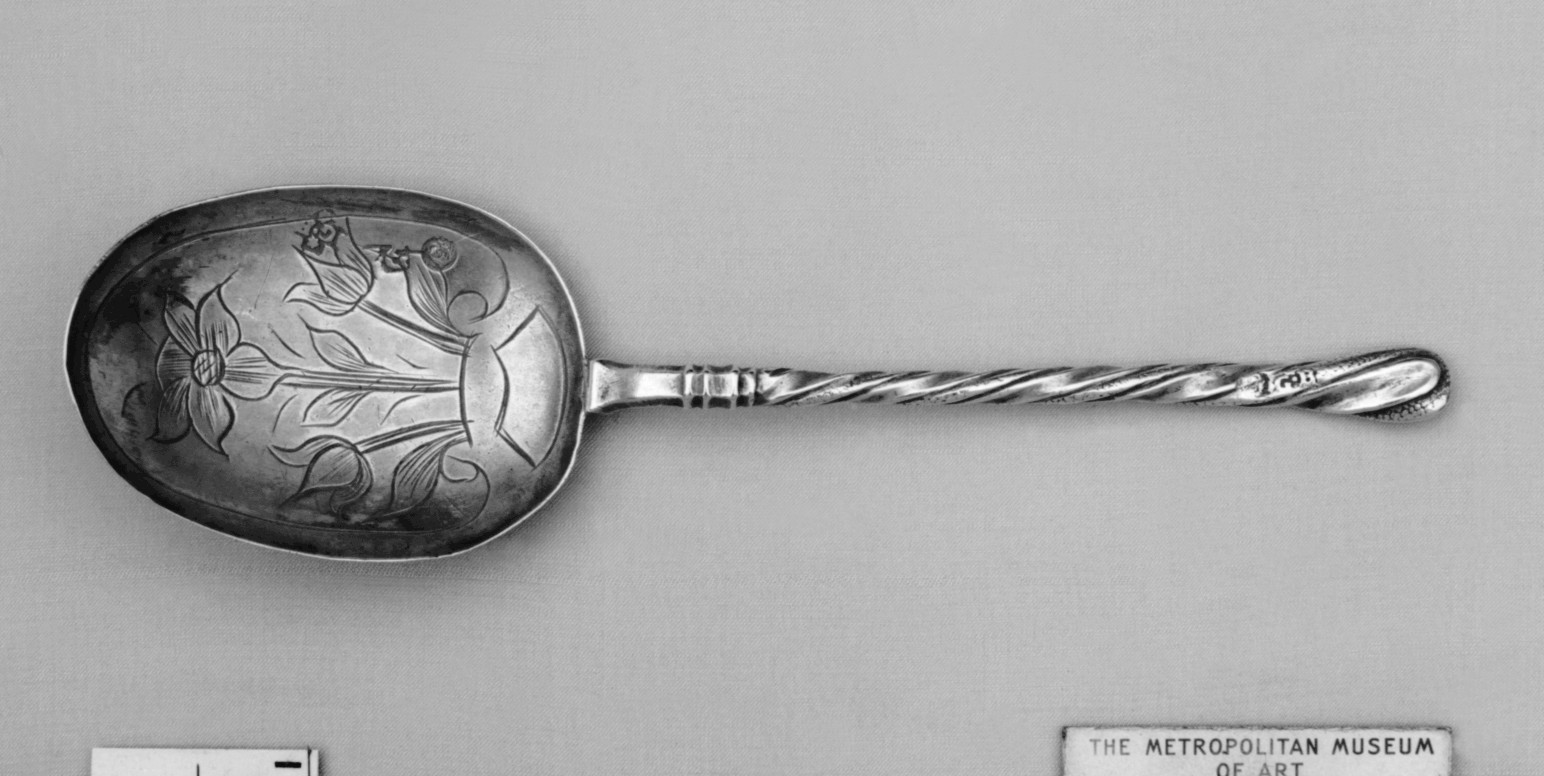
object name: spoon handle section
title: Twisted-stem spoon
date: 1701-1733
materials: silver